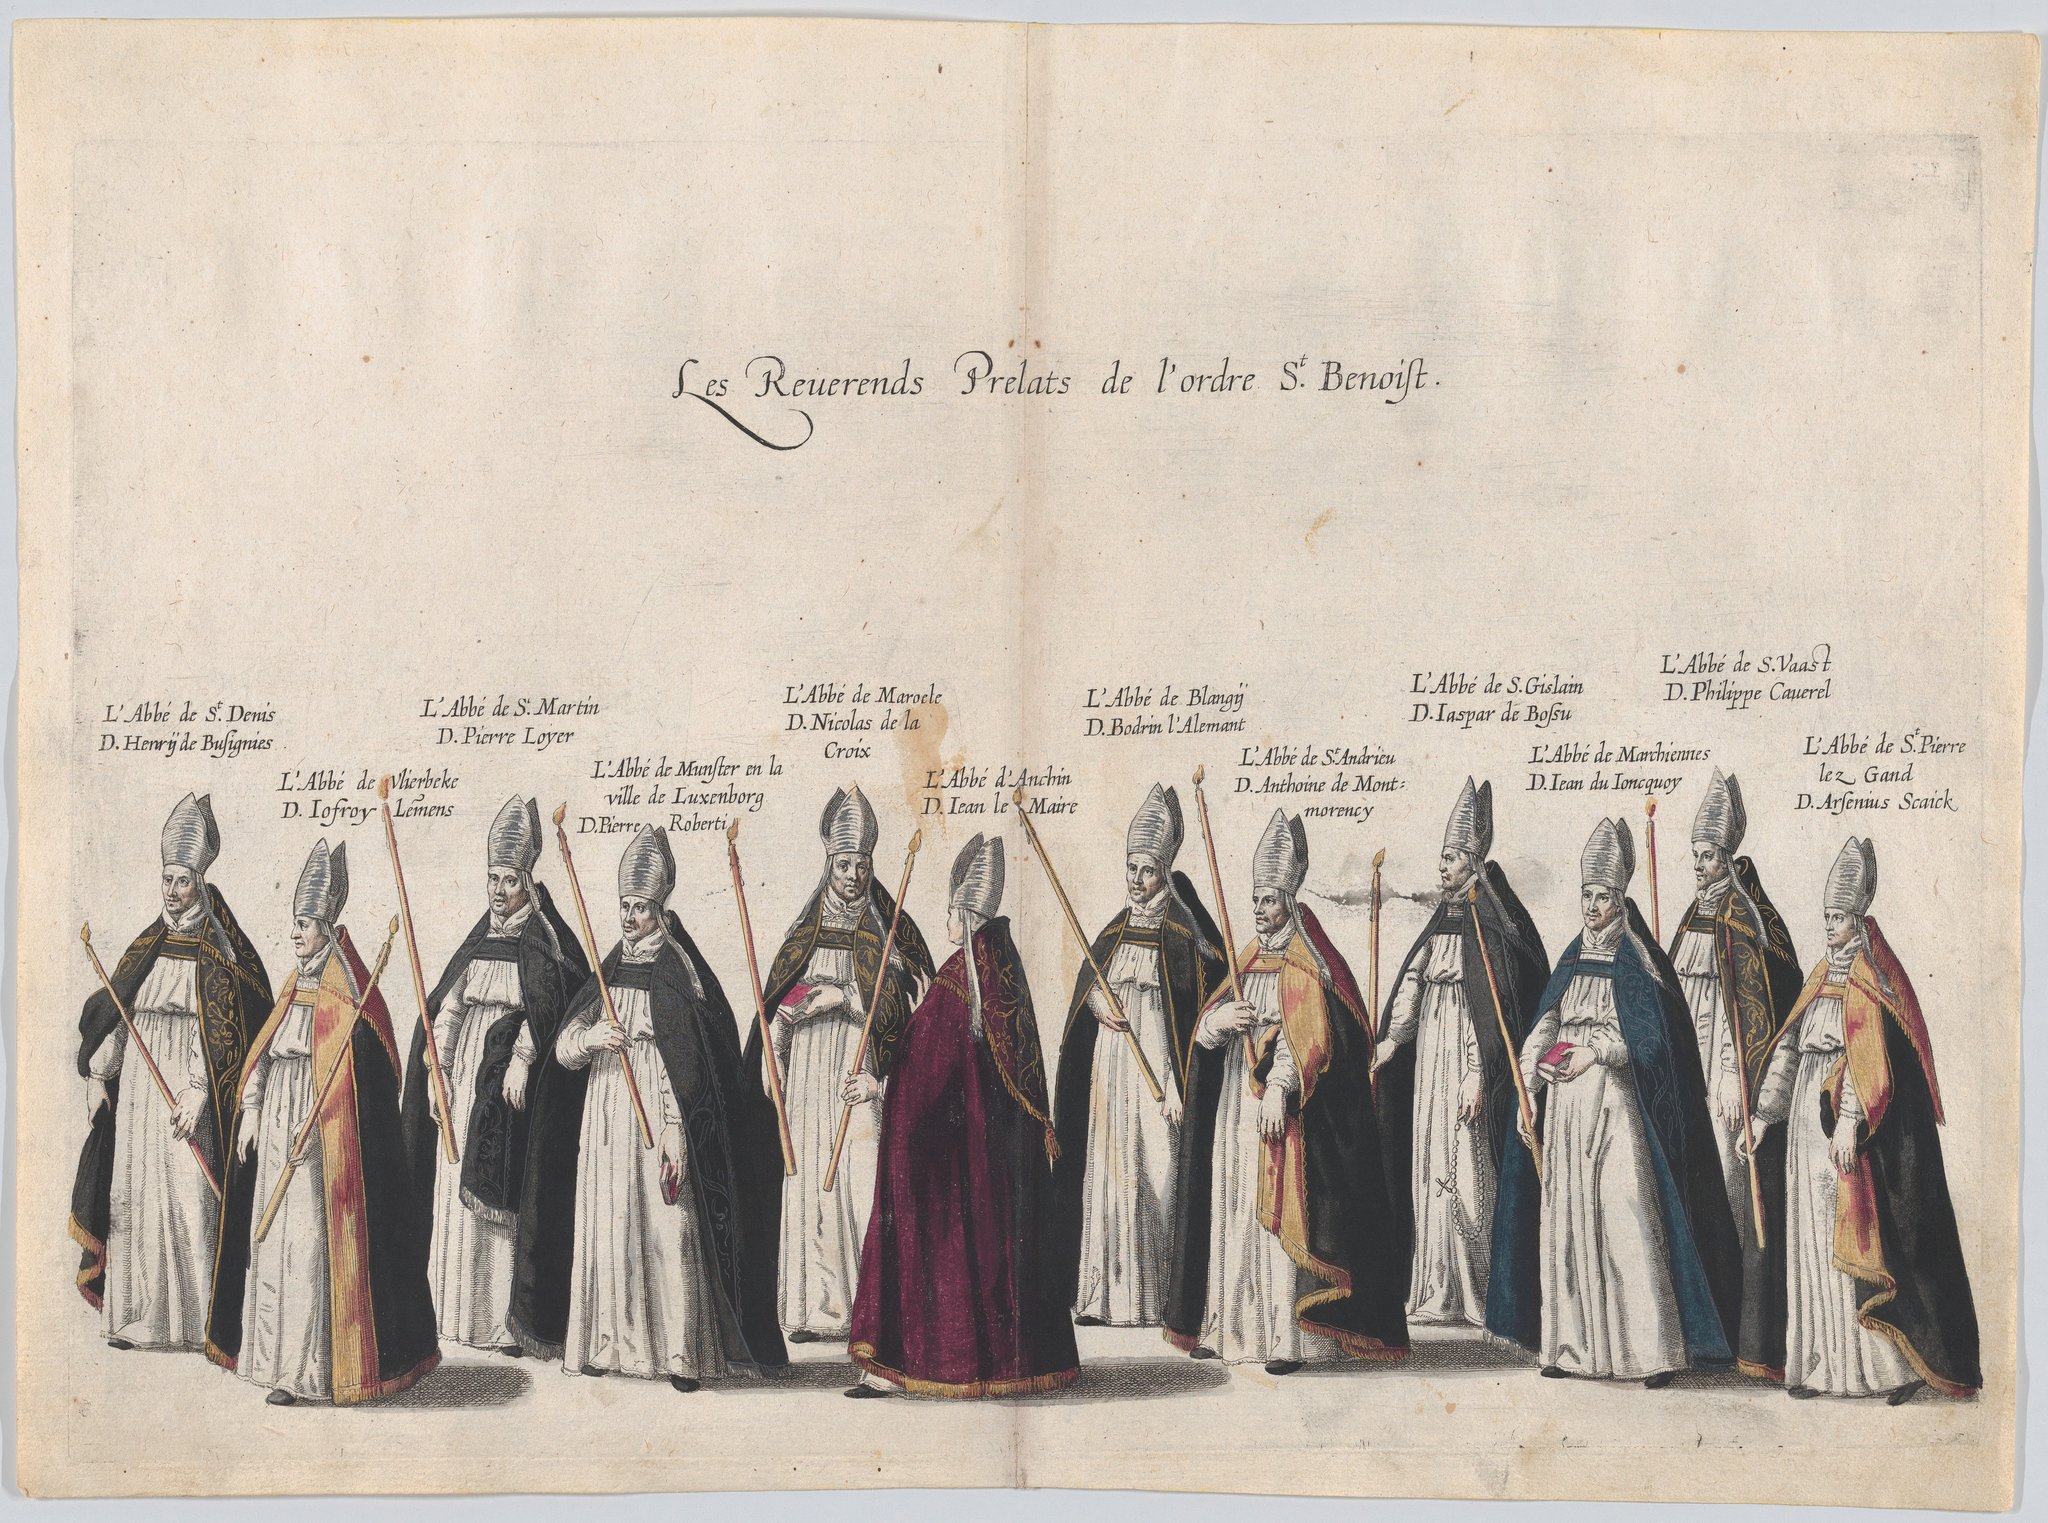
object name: print, fete, ornament architecture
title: Plate 11: Members of the clergy marching in the funeral procession of Archduke Albert of Austria; from 'Pompa Funebris ... Alberti Pii'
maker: cornelis galle (i)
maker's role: artist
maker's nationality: netherlandish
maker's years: 1576-1650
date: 1623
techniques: etching, hand coloring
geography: brussels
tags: men